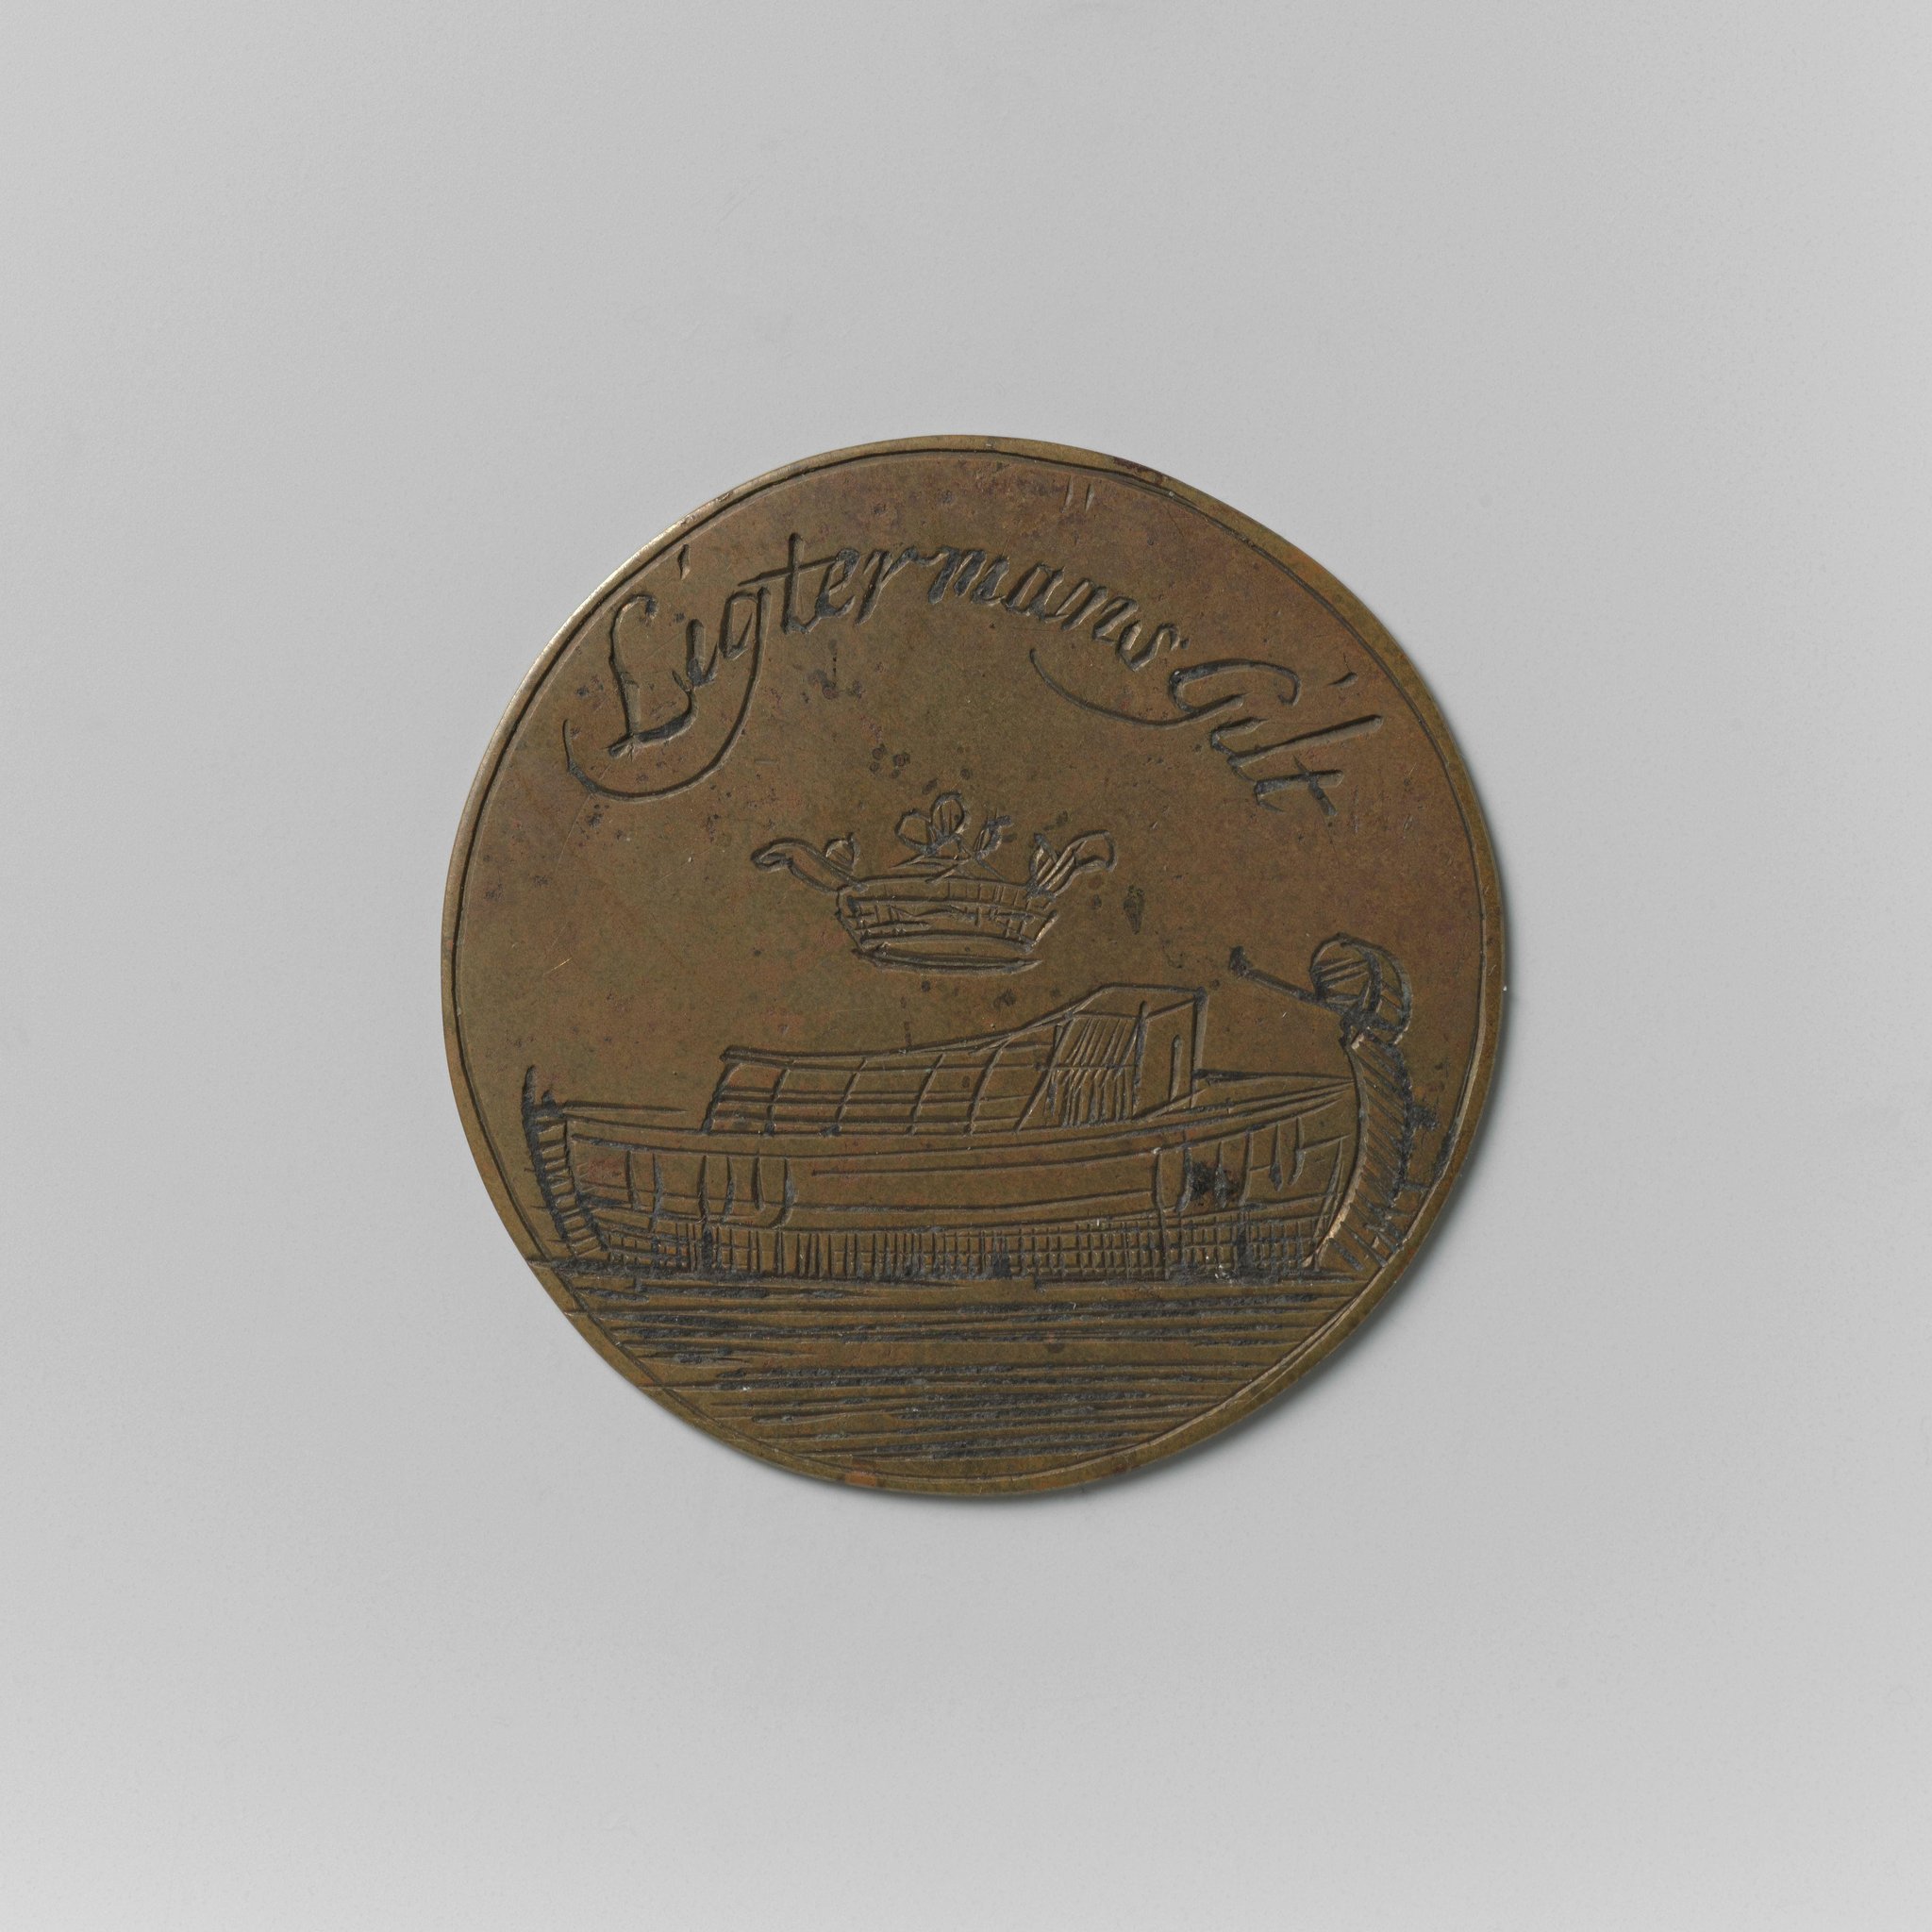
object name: medal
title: Presentiepenning van het Korenlichtermansgilde te Amsterdam, 1735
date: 1735-1777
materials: brass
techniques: engraving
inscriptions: inscription: ‘Lucas / Kampheuve / 20 Septemb' / 1777’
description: Ronde plaat messing gegraveerd op de voorzijde een gekroonde korenlichter met de tekst Ligtermansgilt, op de keerzijde vier regels tekst, op naam van Lucas Kampheuve 20 september 1777